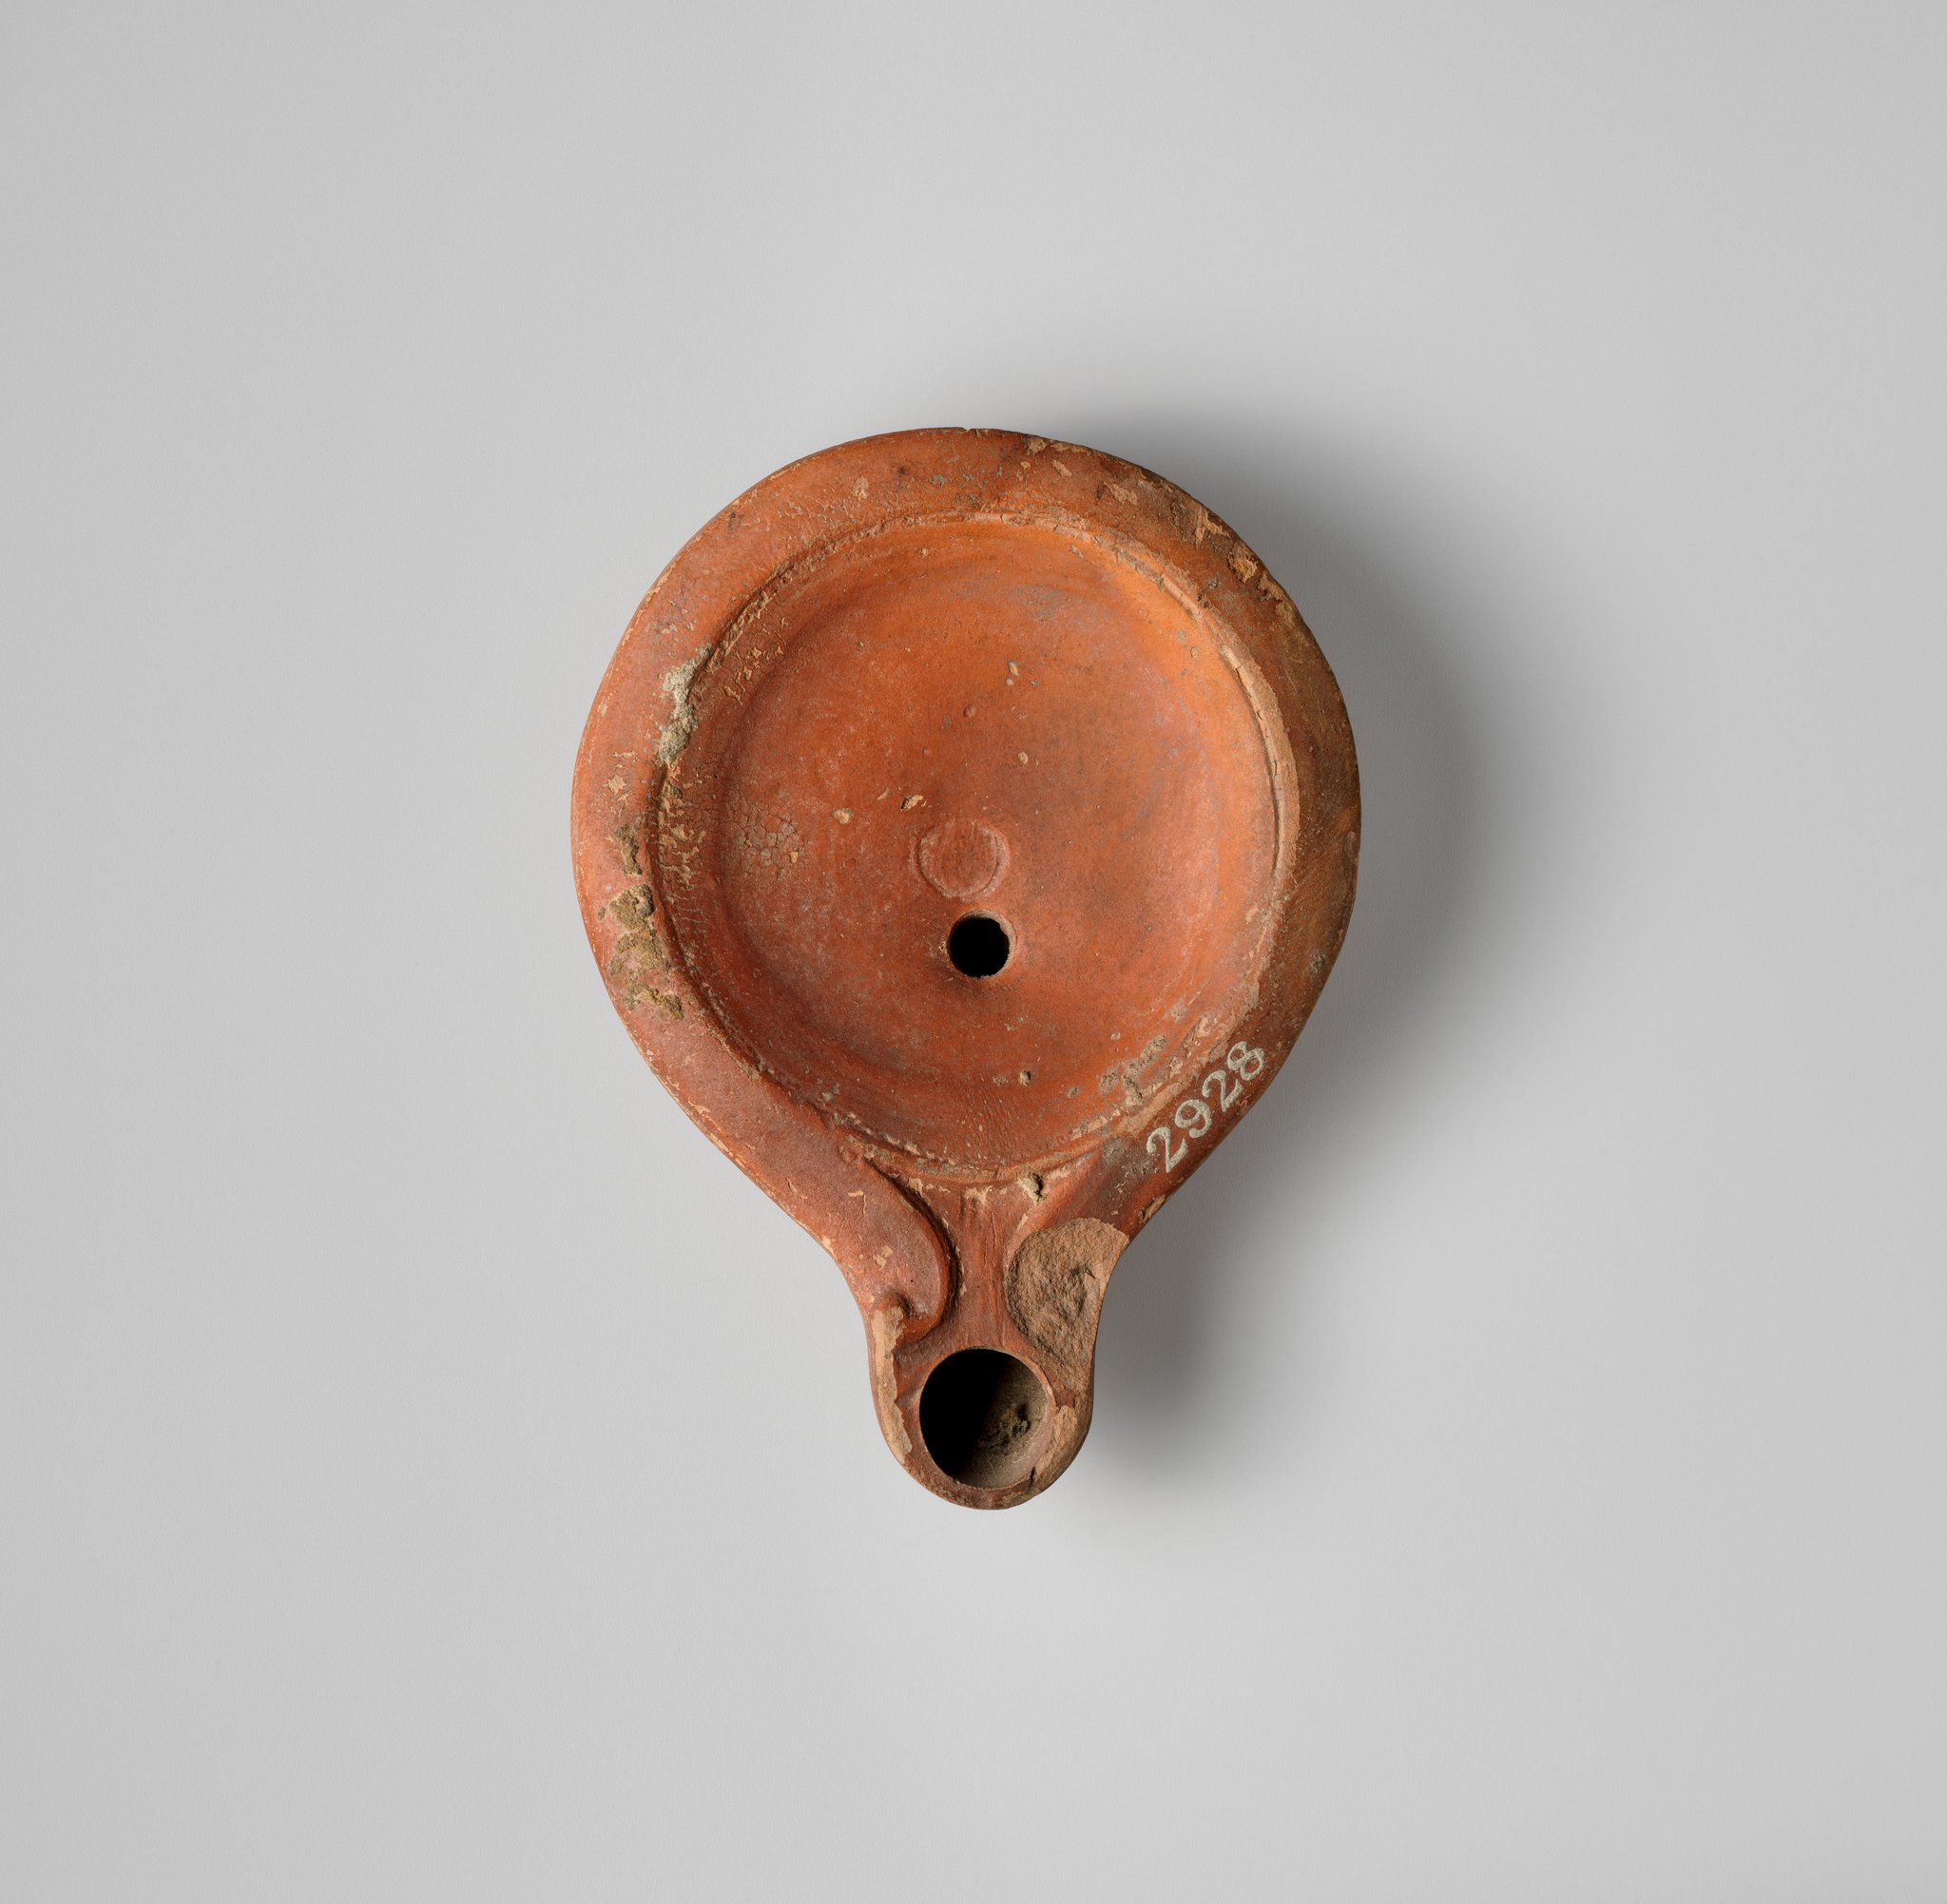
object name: lamp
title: Terracotta oil lamp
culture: roman, cypriot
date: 50-400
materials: terracotta